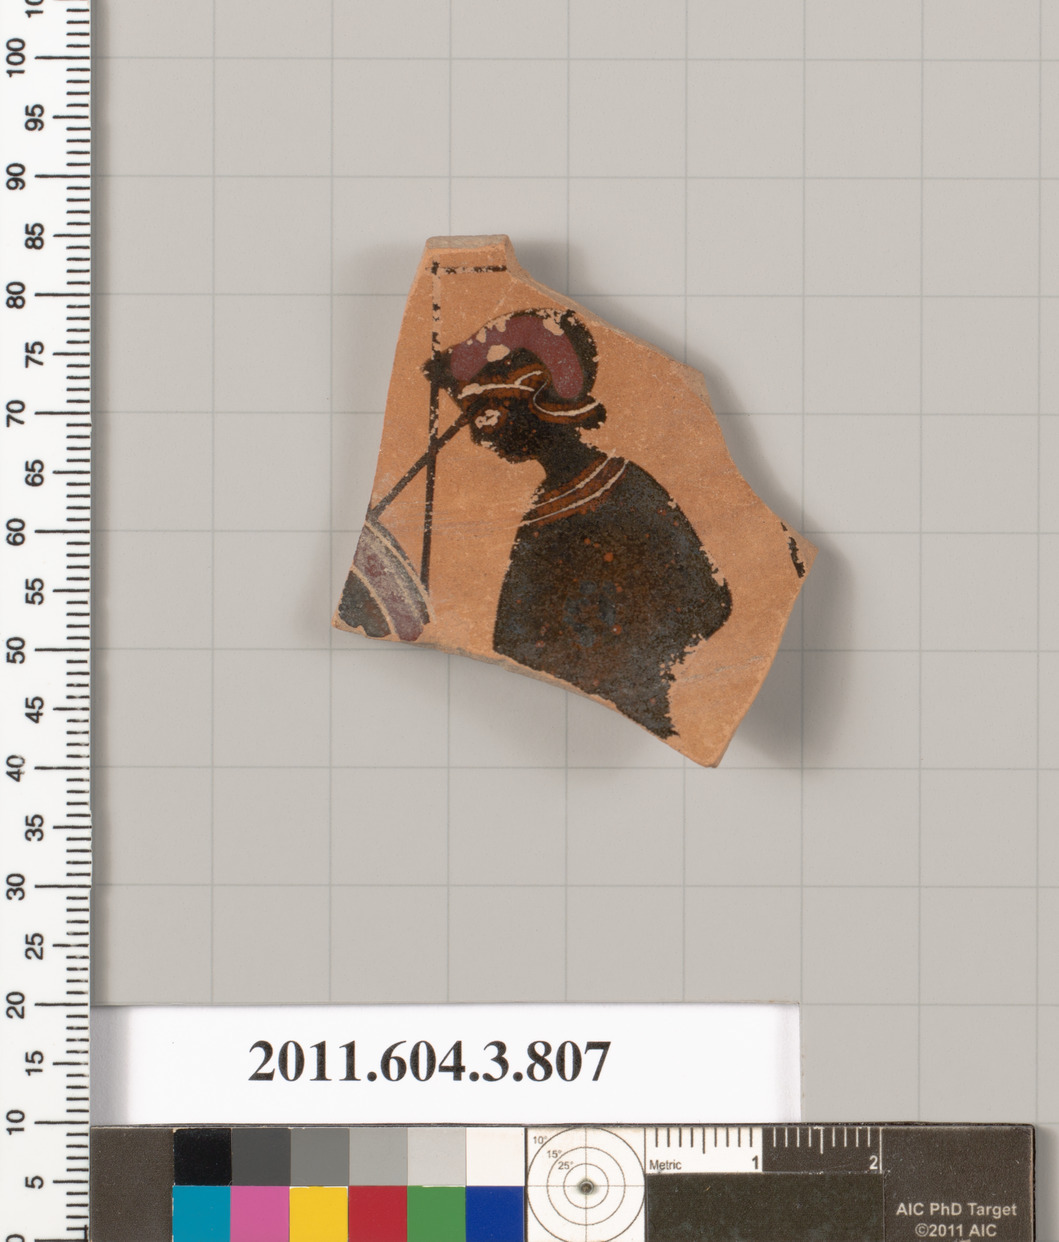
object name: lekythos fragment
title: Terracotta fragment of a lekythos (oil flask)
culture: greek, attic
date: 550-526 BCE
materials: terracotta